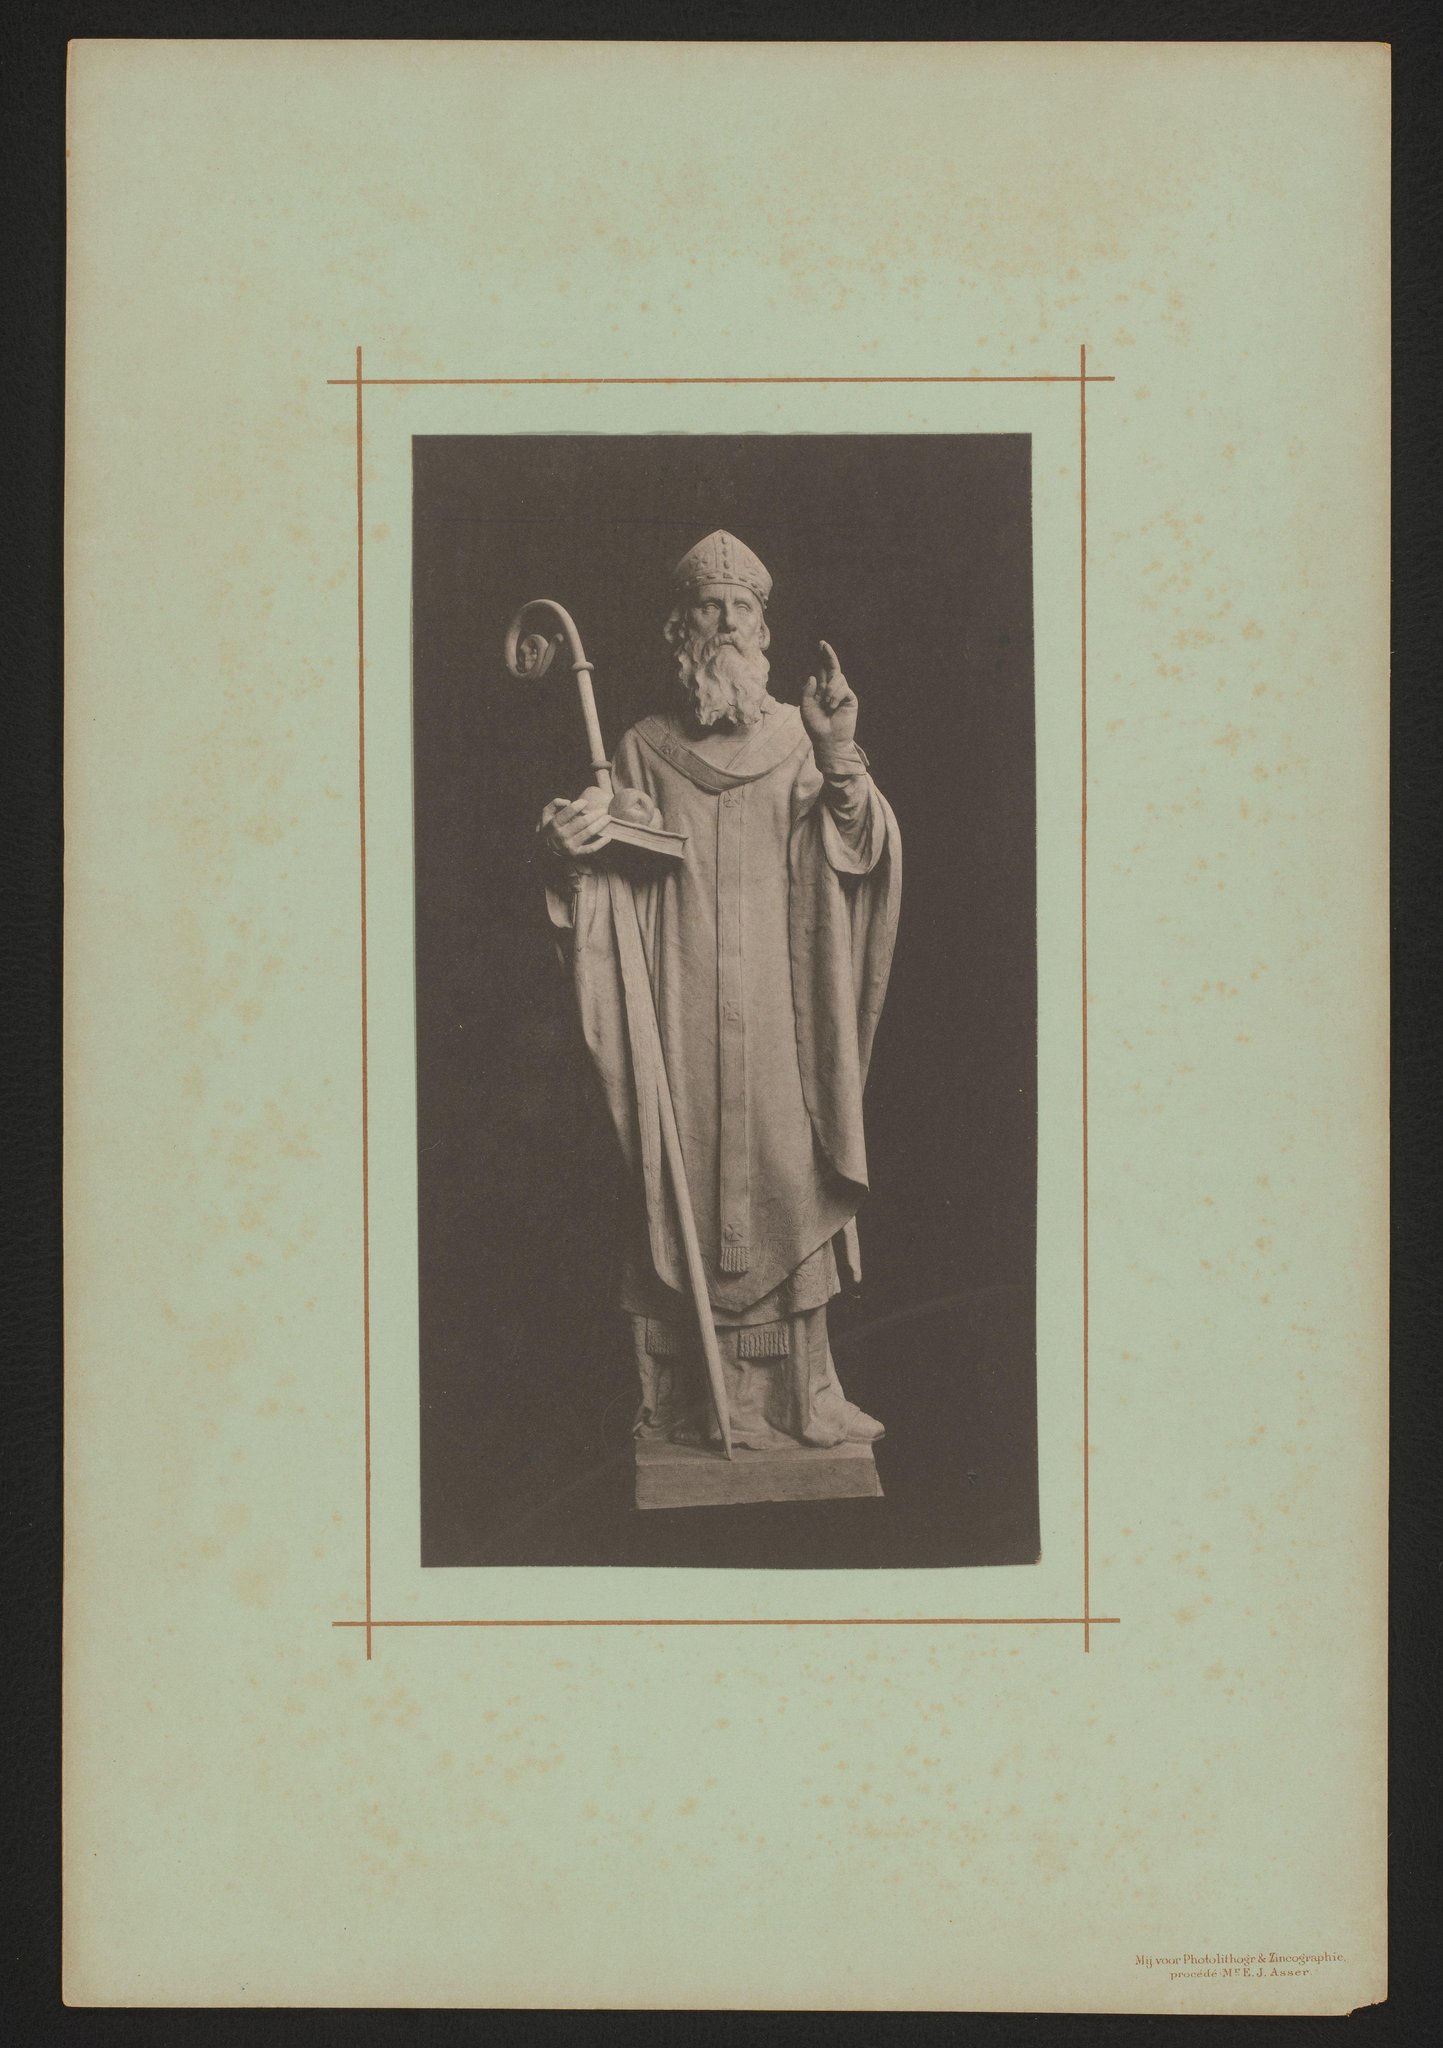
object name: album leaf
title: Beeld van een bisschop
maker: Anonymous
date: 1892-1900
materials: paper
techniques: photograph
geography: amsterdam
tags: archbishop, bishop, etc. (roman catholic)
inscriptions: inscription: ‘Mij. voor Photolithogr & Zincographie/ procédé Mr. E.J. Asser.’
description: Deze prent maakt deel uit van een album.